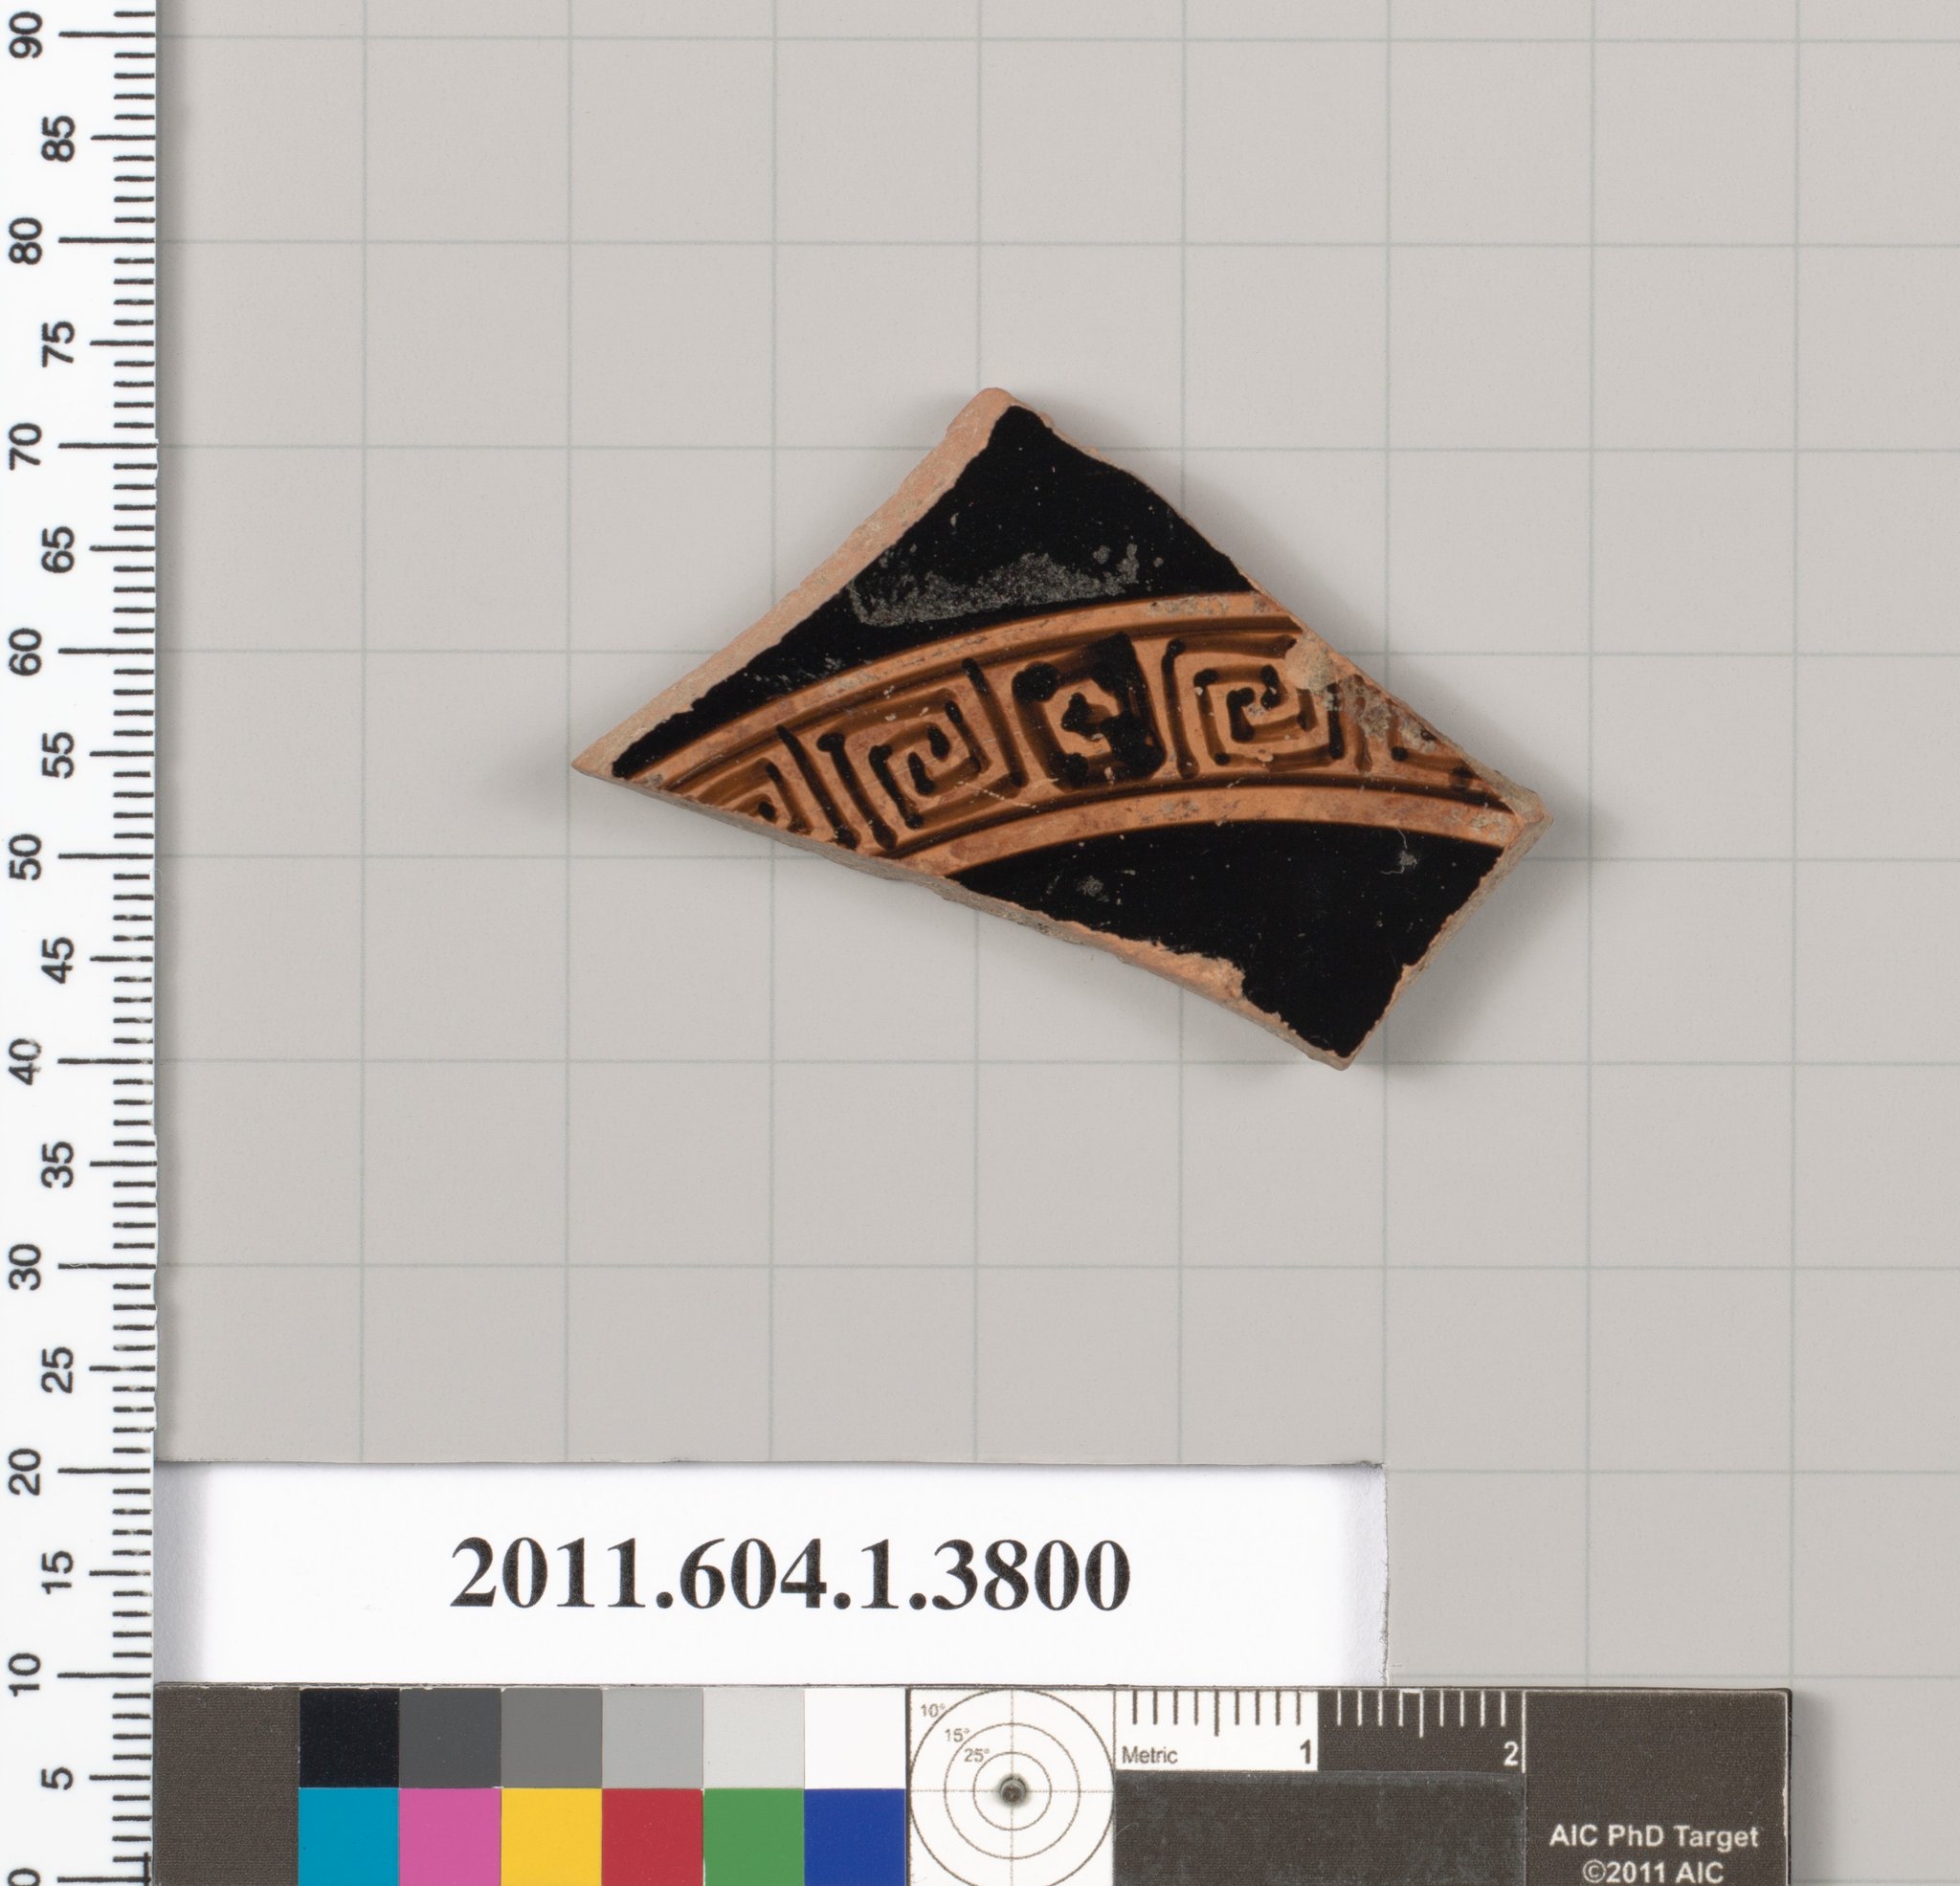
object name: kylix fragment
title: Terracotta fragment of a kylix (drinking cup)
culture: greek, attic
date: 460-450 BCE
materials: terracotta